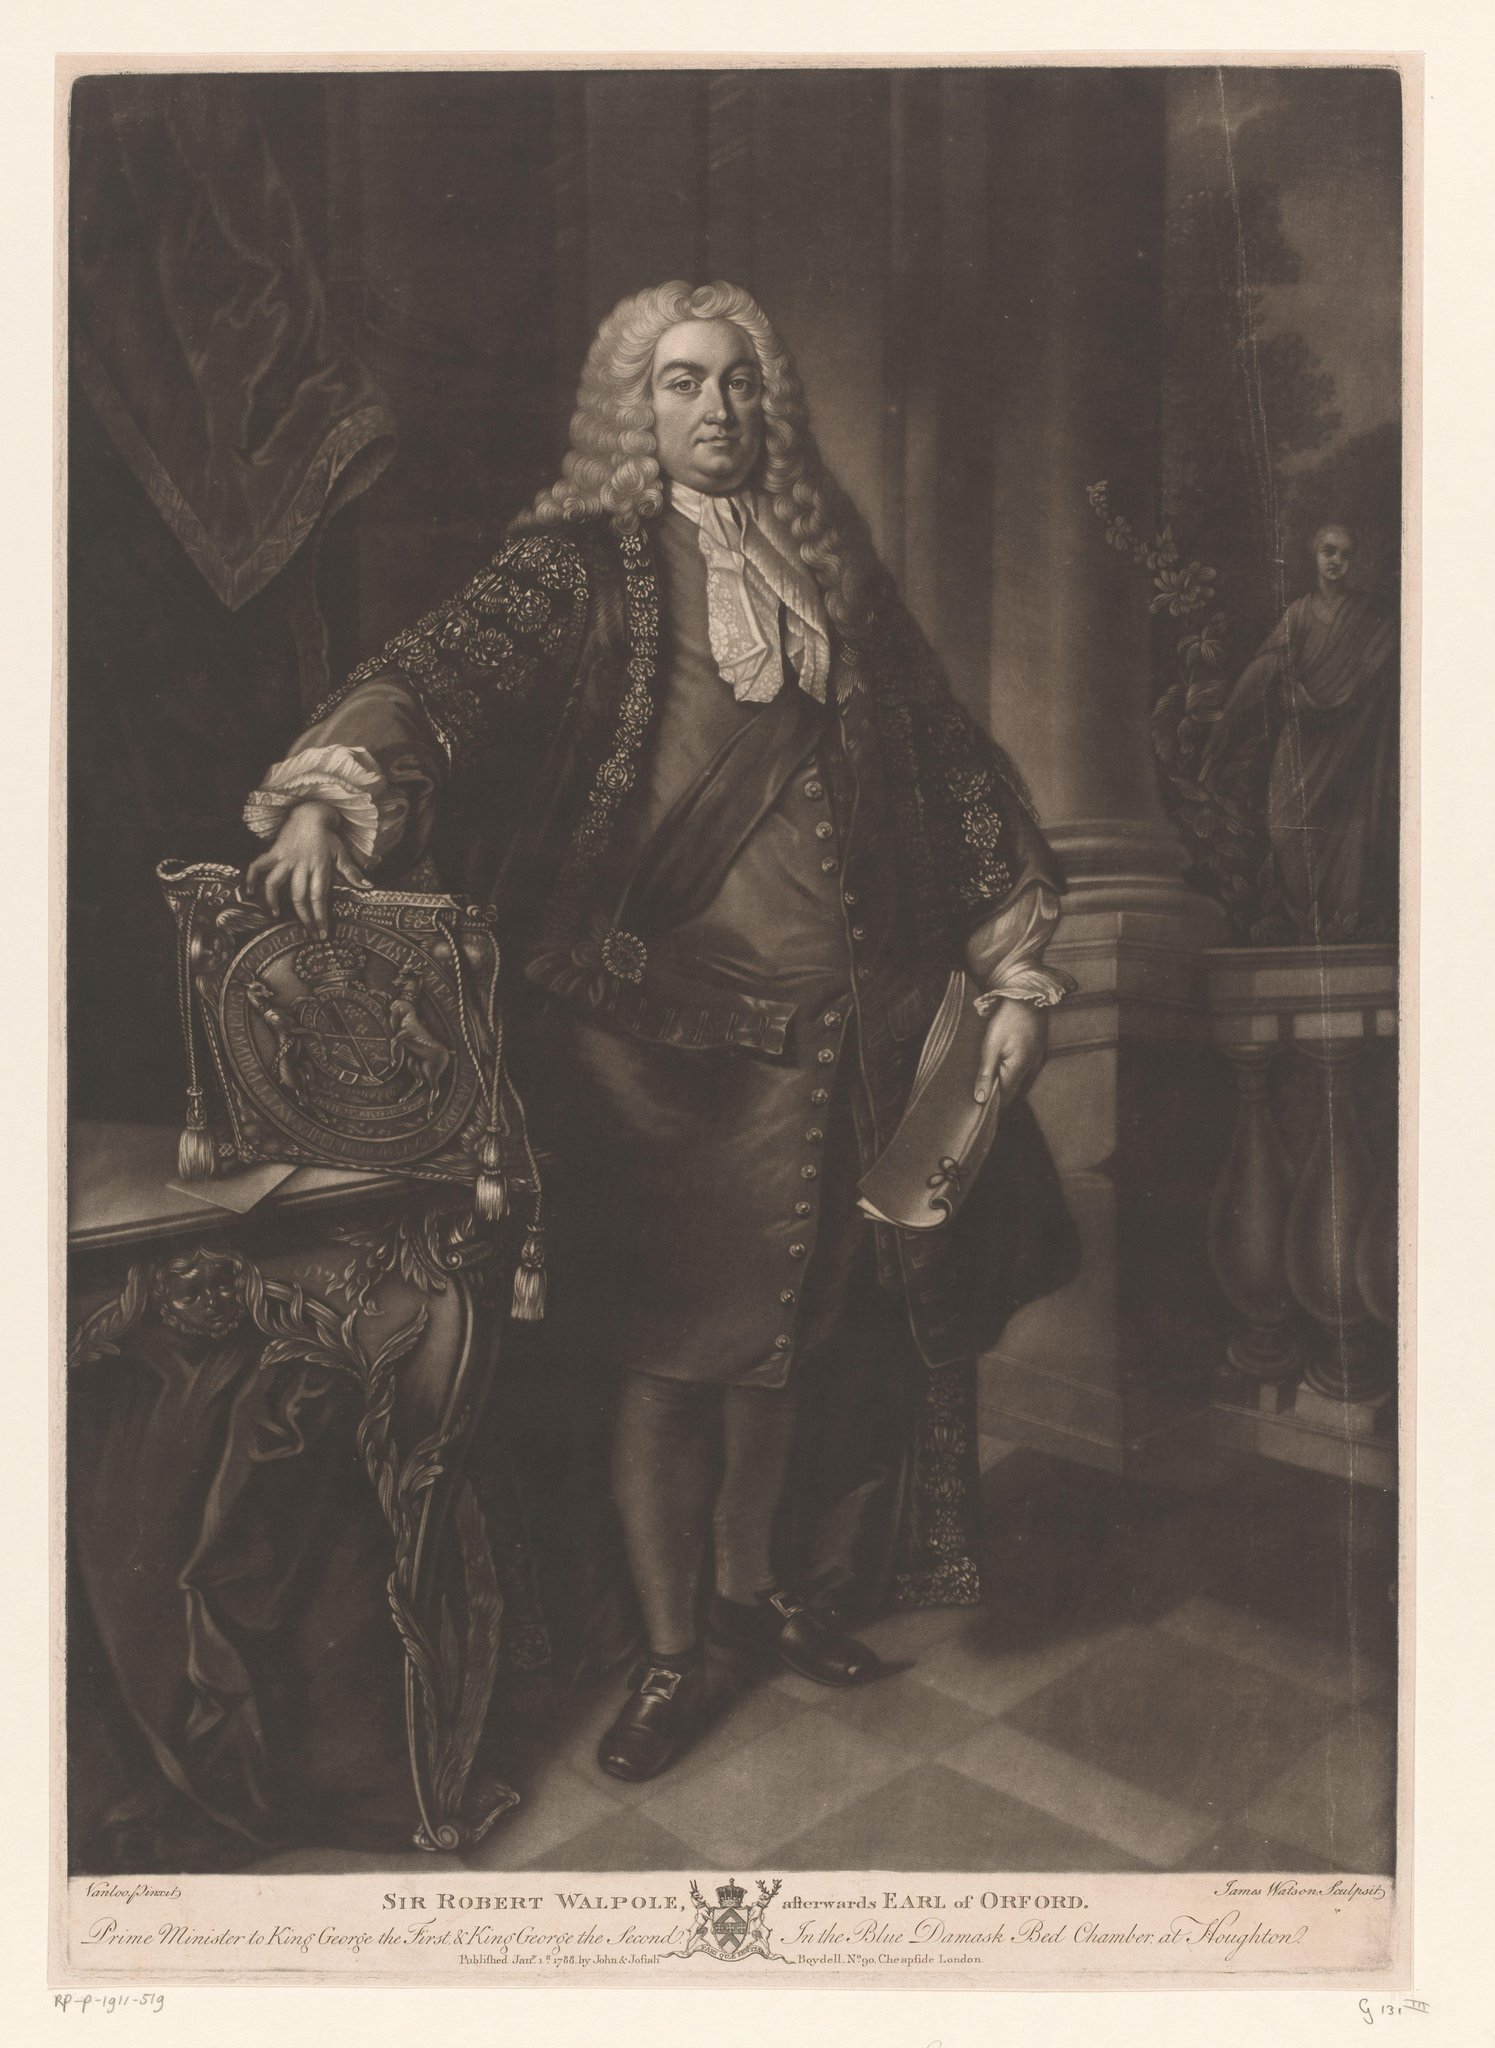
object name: print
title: Portret van Robert Walpole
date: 1788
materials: paper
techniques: mezzotint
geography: london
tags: politician, robert walpole, historical persons, other utensils used in the church: burse, politician, e.g. party leader, statues, sculptures in garden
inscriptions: collector's mark: Lugt 2228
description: Prent is onderdeel van een serie van 162 prenten naar schilderijen uit de collectie van Sir Robert Walpole in Houghton, op initiatief van uitgever John Boydell. Deze prent was de titelprent van deel 2.